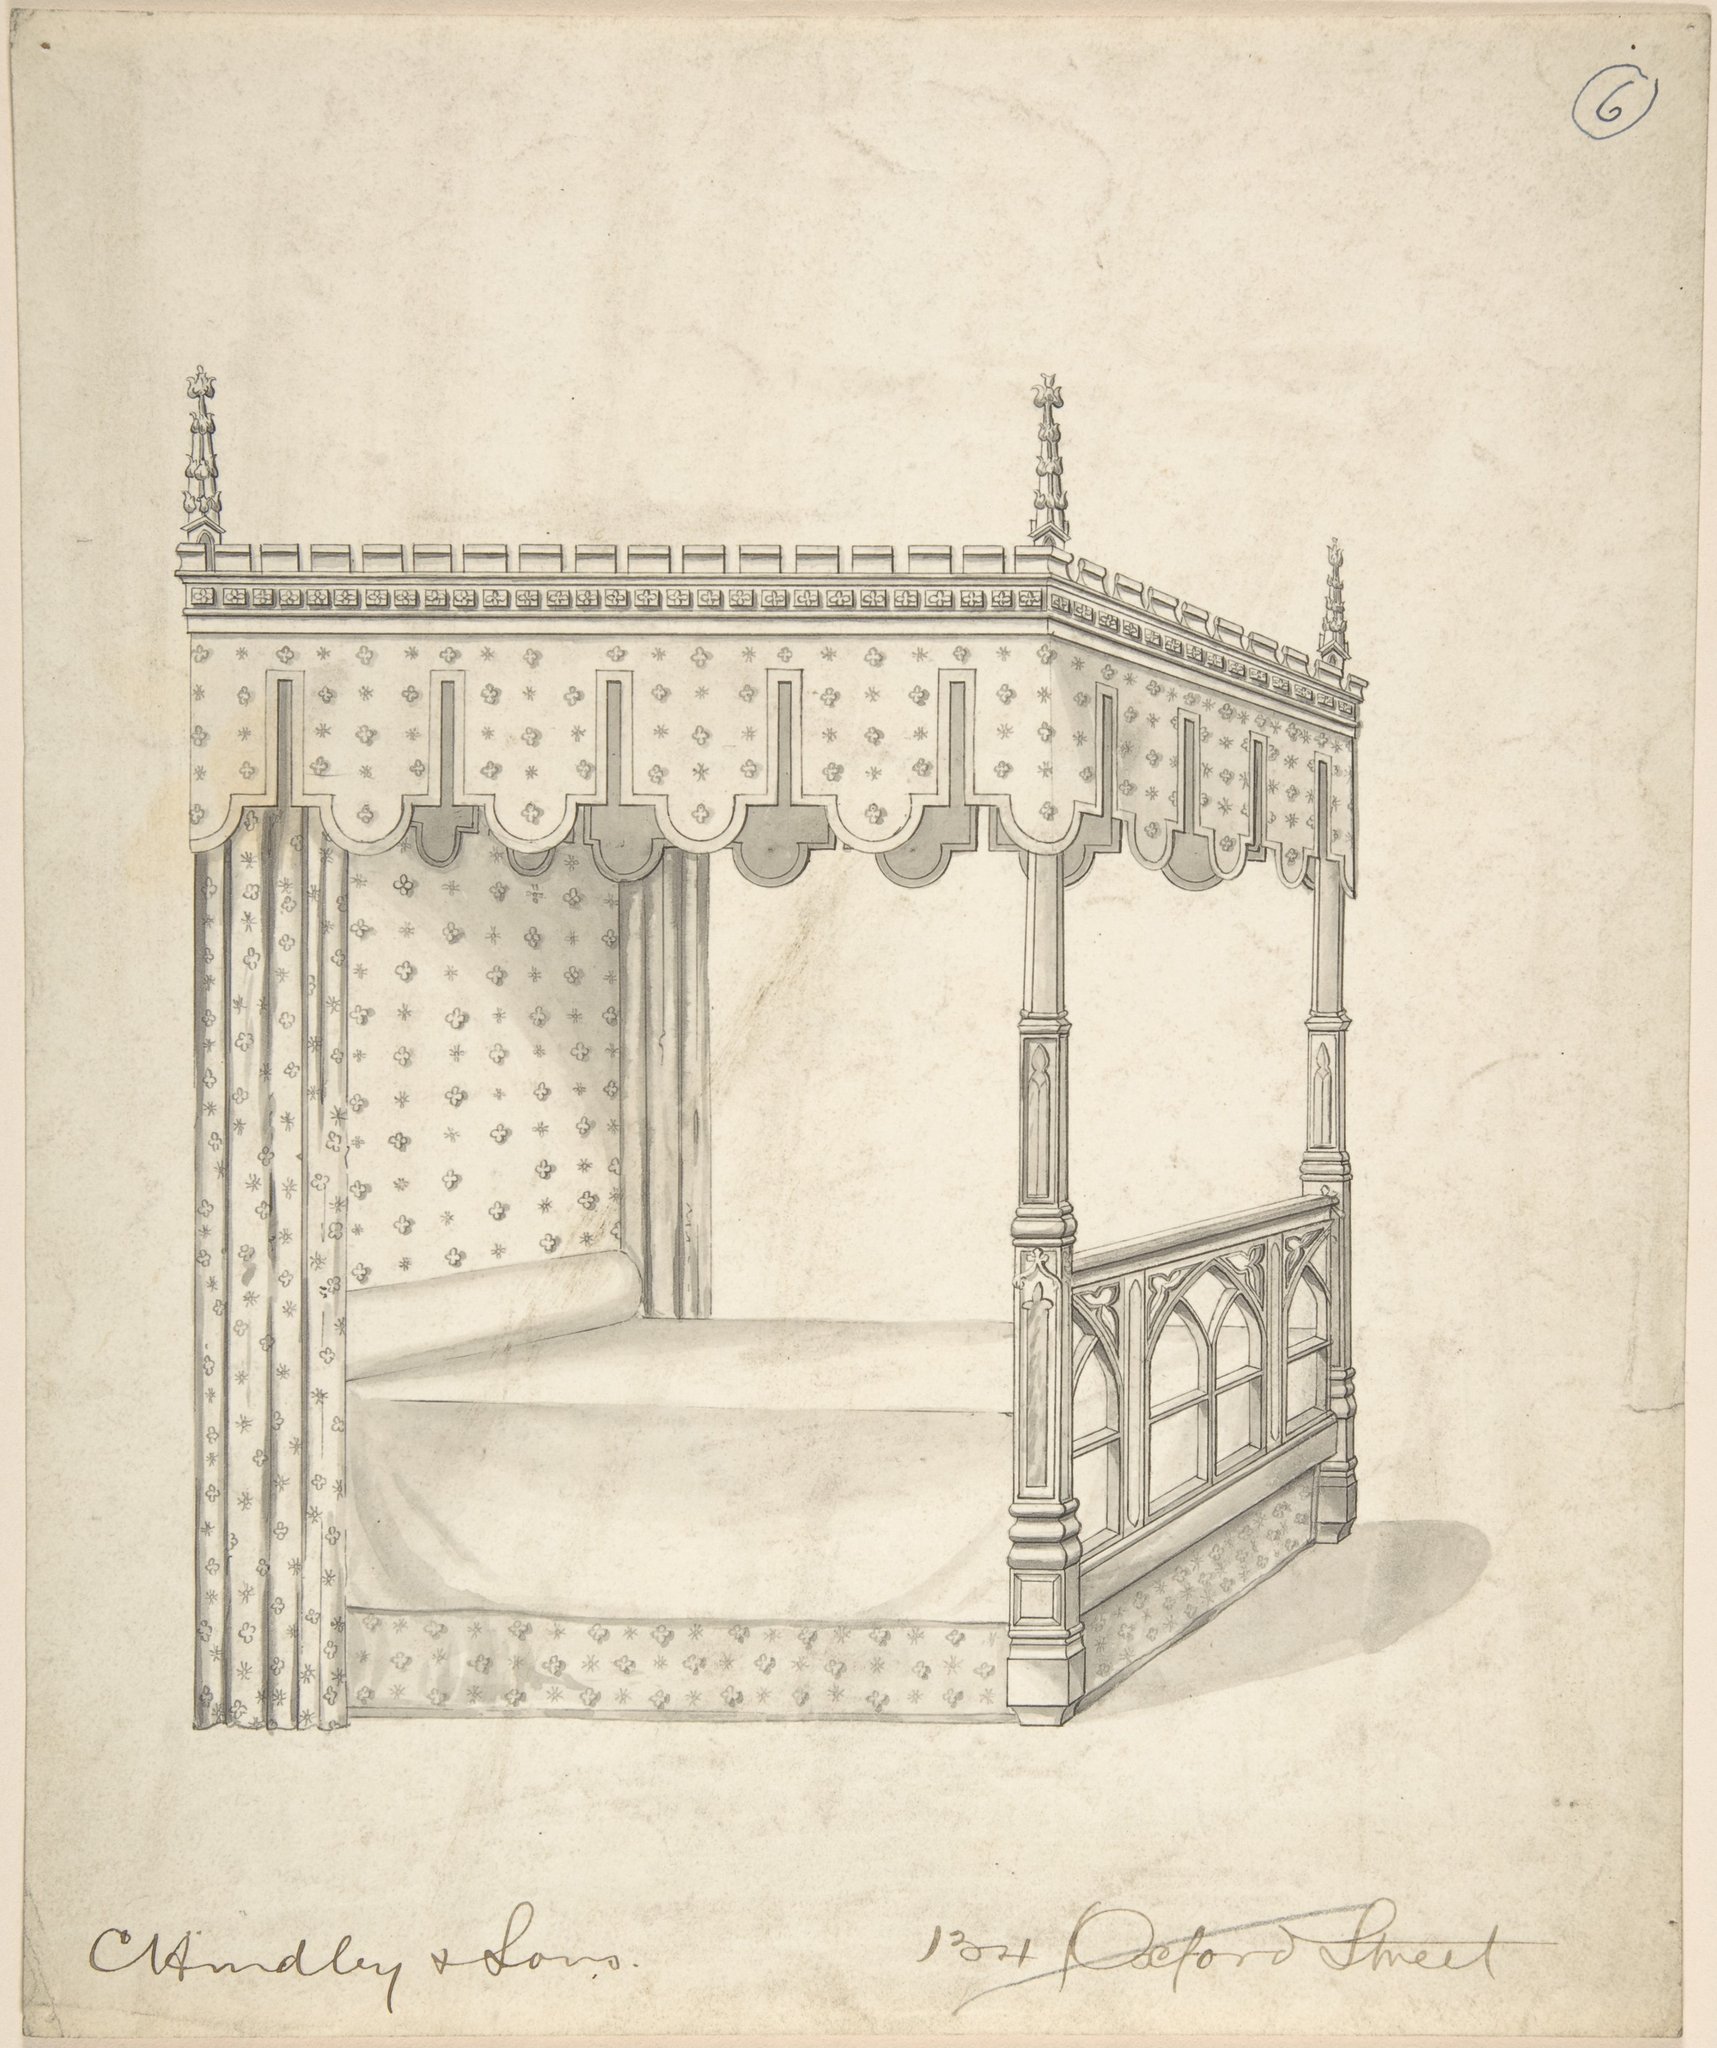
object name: drawing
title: Design for a Gothic Bed with Canopy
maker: charles hindley and sons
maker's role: artist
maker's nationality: british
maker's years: 1841-1917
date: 1841-1884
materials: ink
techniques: pen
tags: beds